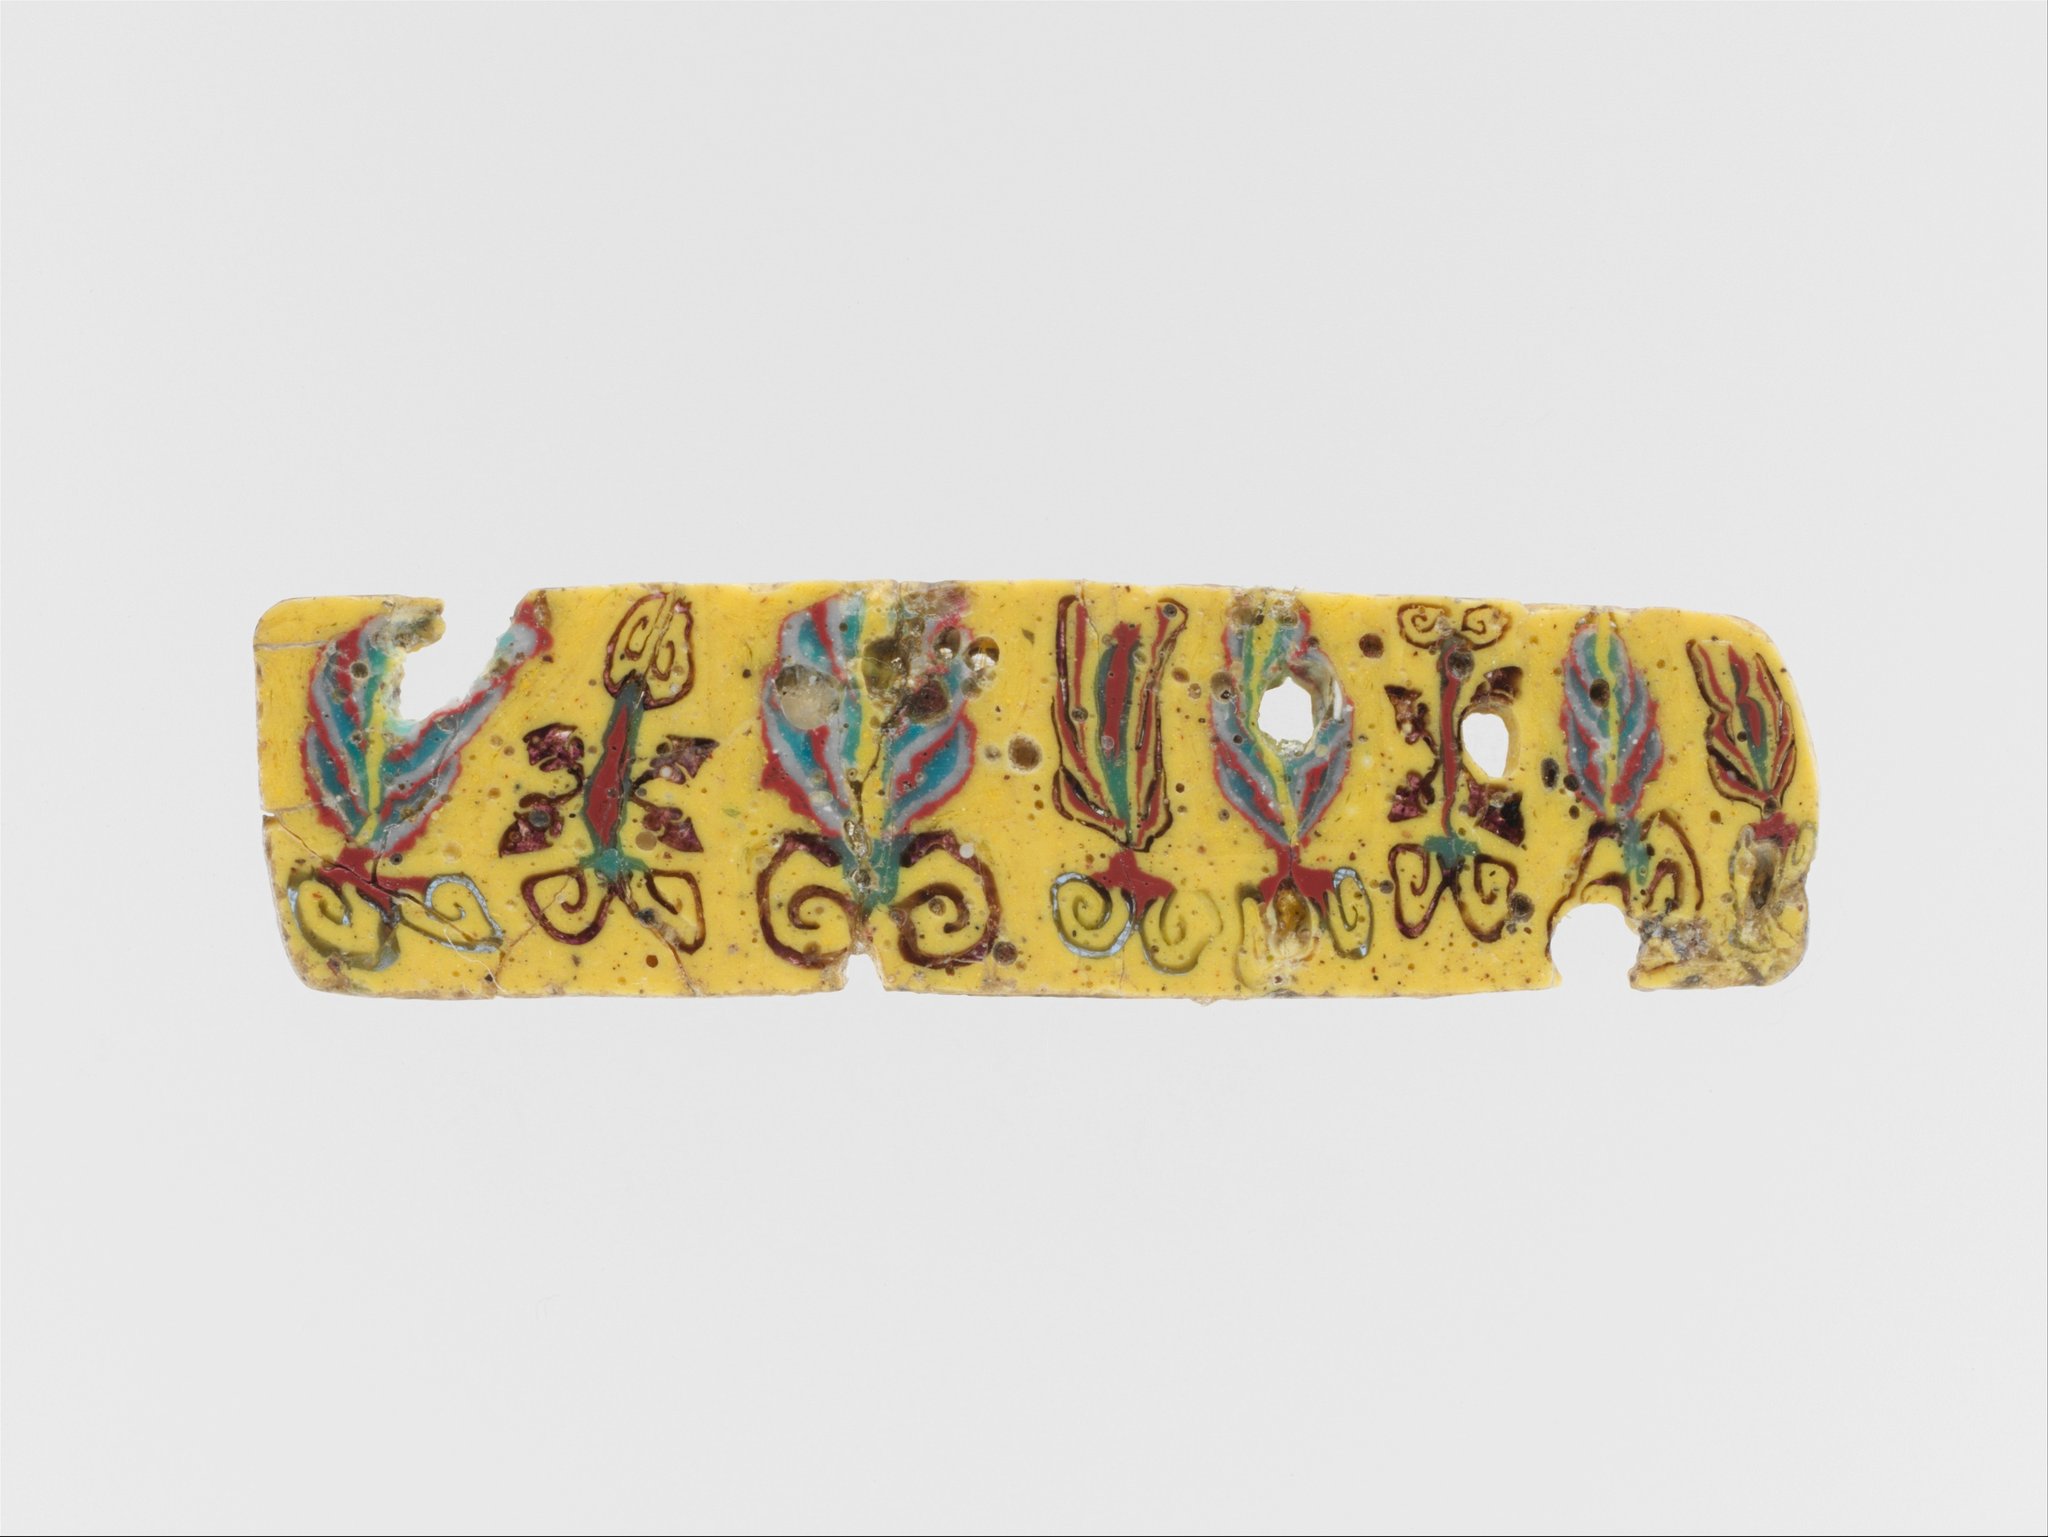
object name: mosaic block inlay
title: Glass mosaic inlay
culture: egyptian or roman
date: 100 BCE-100 CE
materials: glass